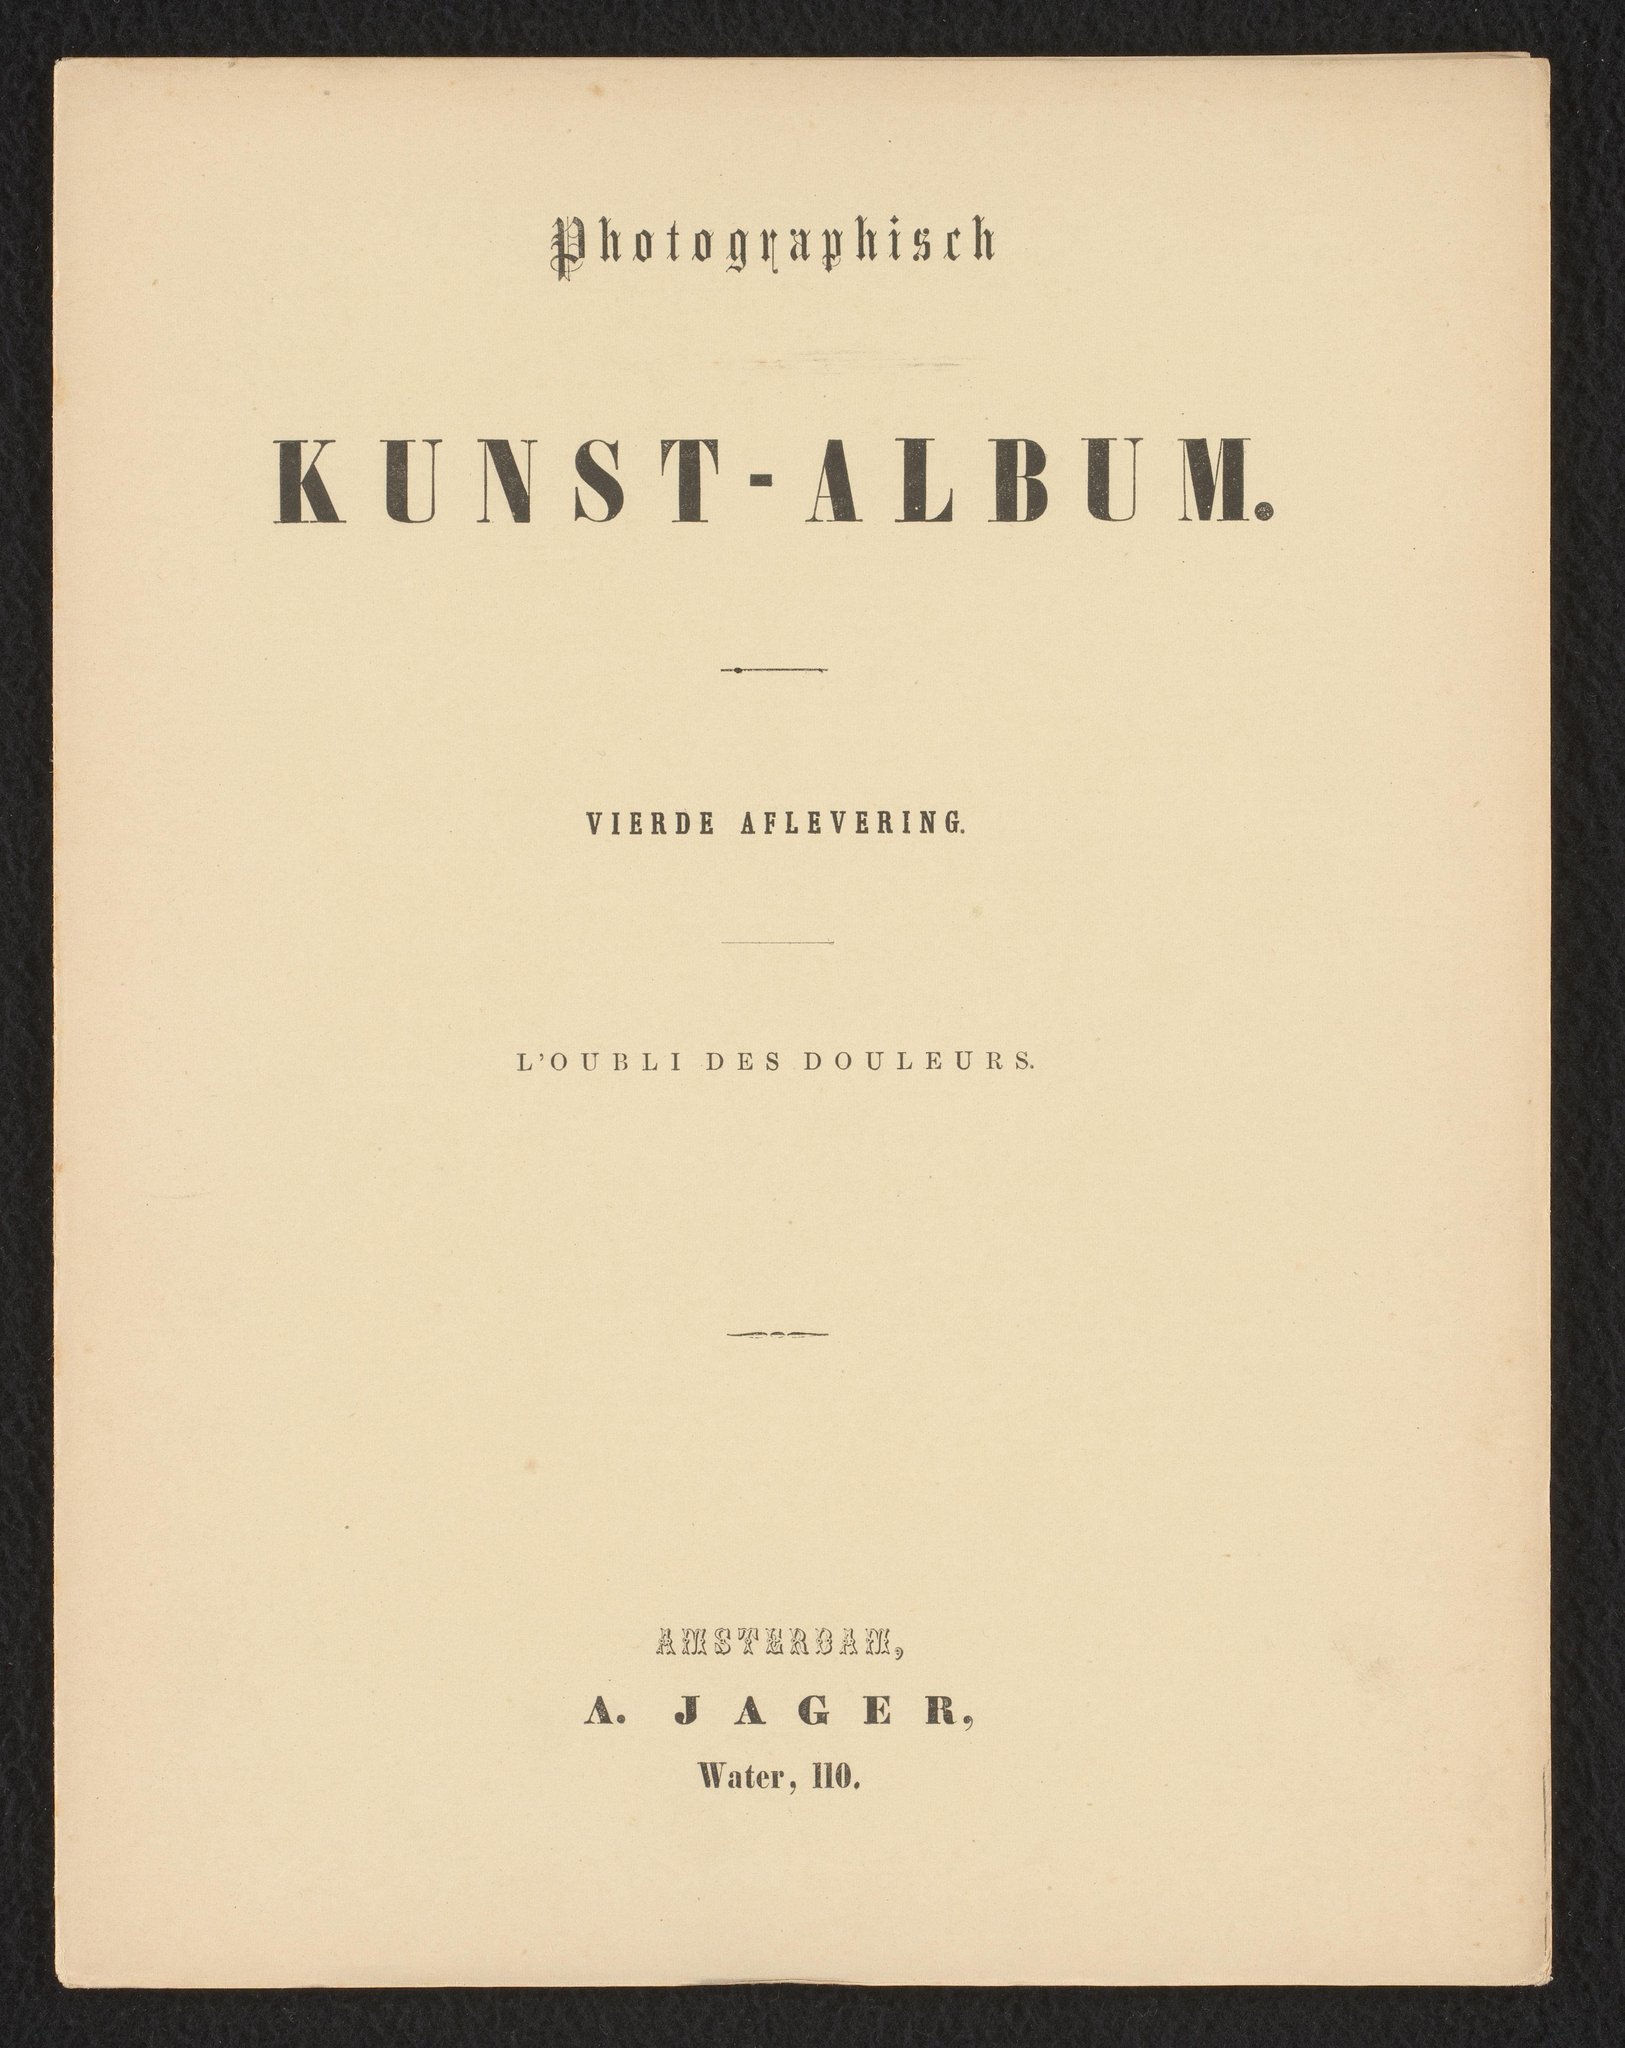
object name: wrapper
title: Vierde aflevering. l'Oubli des Douleurs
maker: andries jager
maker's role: publisher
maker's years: 1825-1905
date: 1860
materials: paper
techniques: printing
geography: amsterdam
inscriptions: inscription: ‘L'OUBLI DES DOULEURS/ NAAR EENE SCHILDERIJ/ VAN/ L. GALLAIT.’, address: ‘AMSTERDAM,/ A. JAGER,/ Water, 110.’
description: Deze omslag maakt deel uit van een omslag met twaalf fotoreproducties.